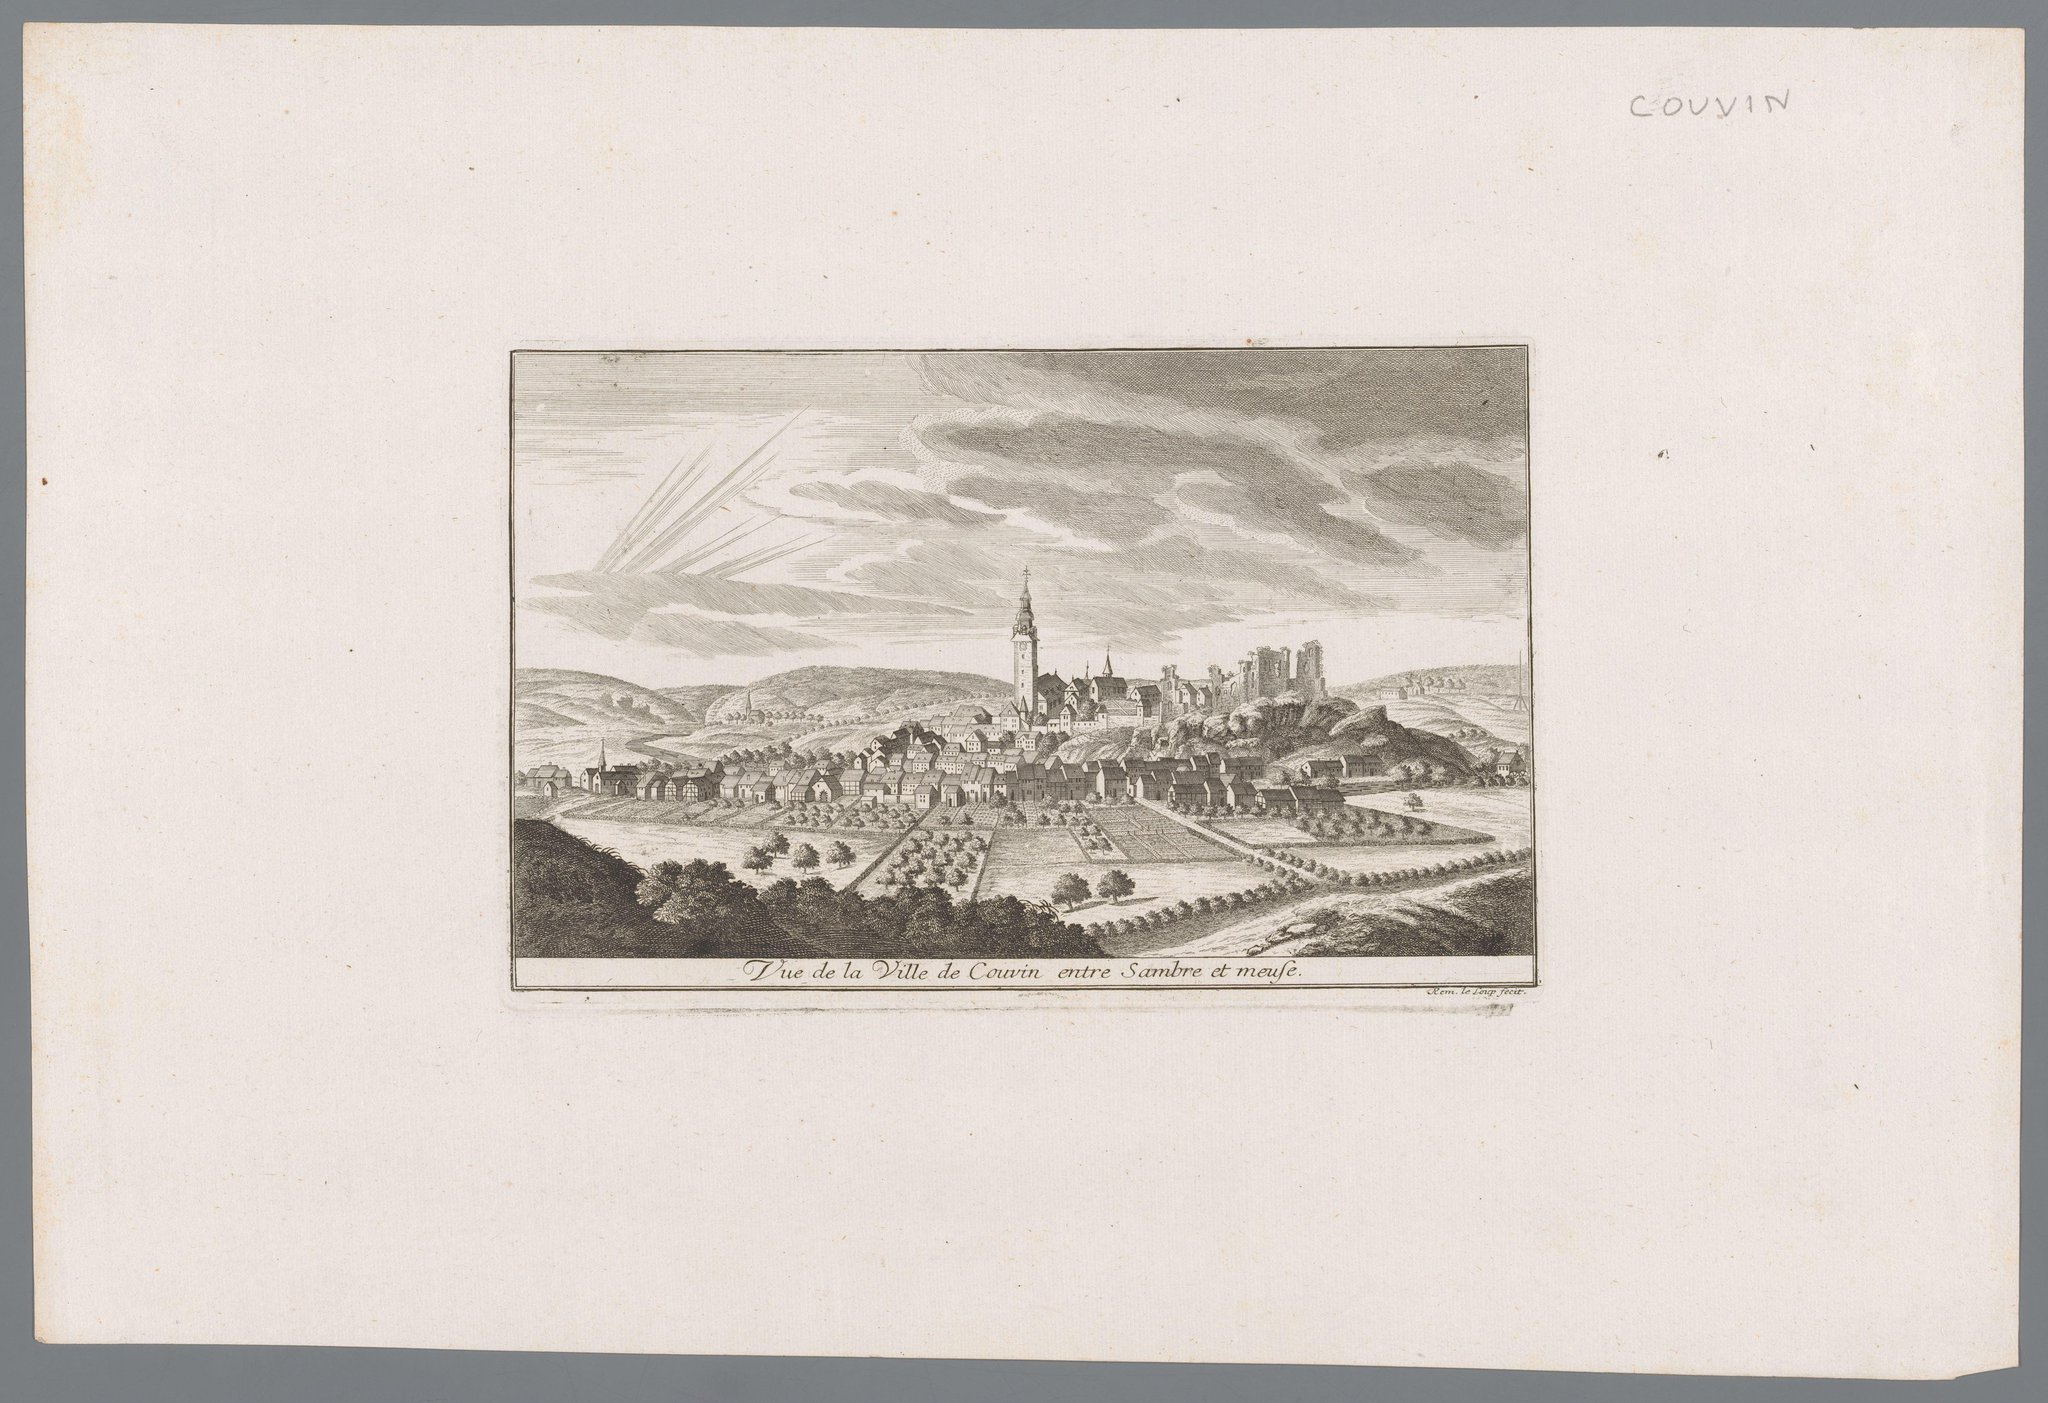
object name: print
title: Vûe de la ville de Couvin entre Sambre et Meuse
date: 1738-1744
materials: paper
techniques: engraving, etching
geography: liège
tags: prospect of village, silhouette of village, liège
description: Prent uit: Johanne de Saumery, Alexandre de et al. Les délices du païs de Liège, ou description géographique, topographique et chorographique des monumes sacrés et profanes (...). 5 dln. Luik: Everard Kints, 1738-1744, dl. 2, p. 294-295.